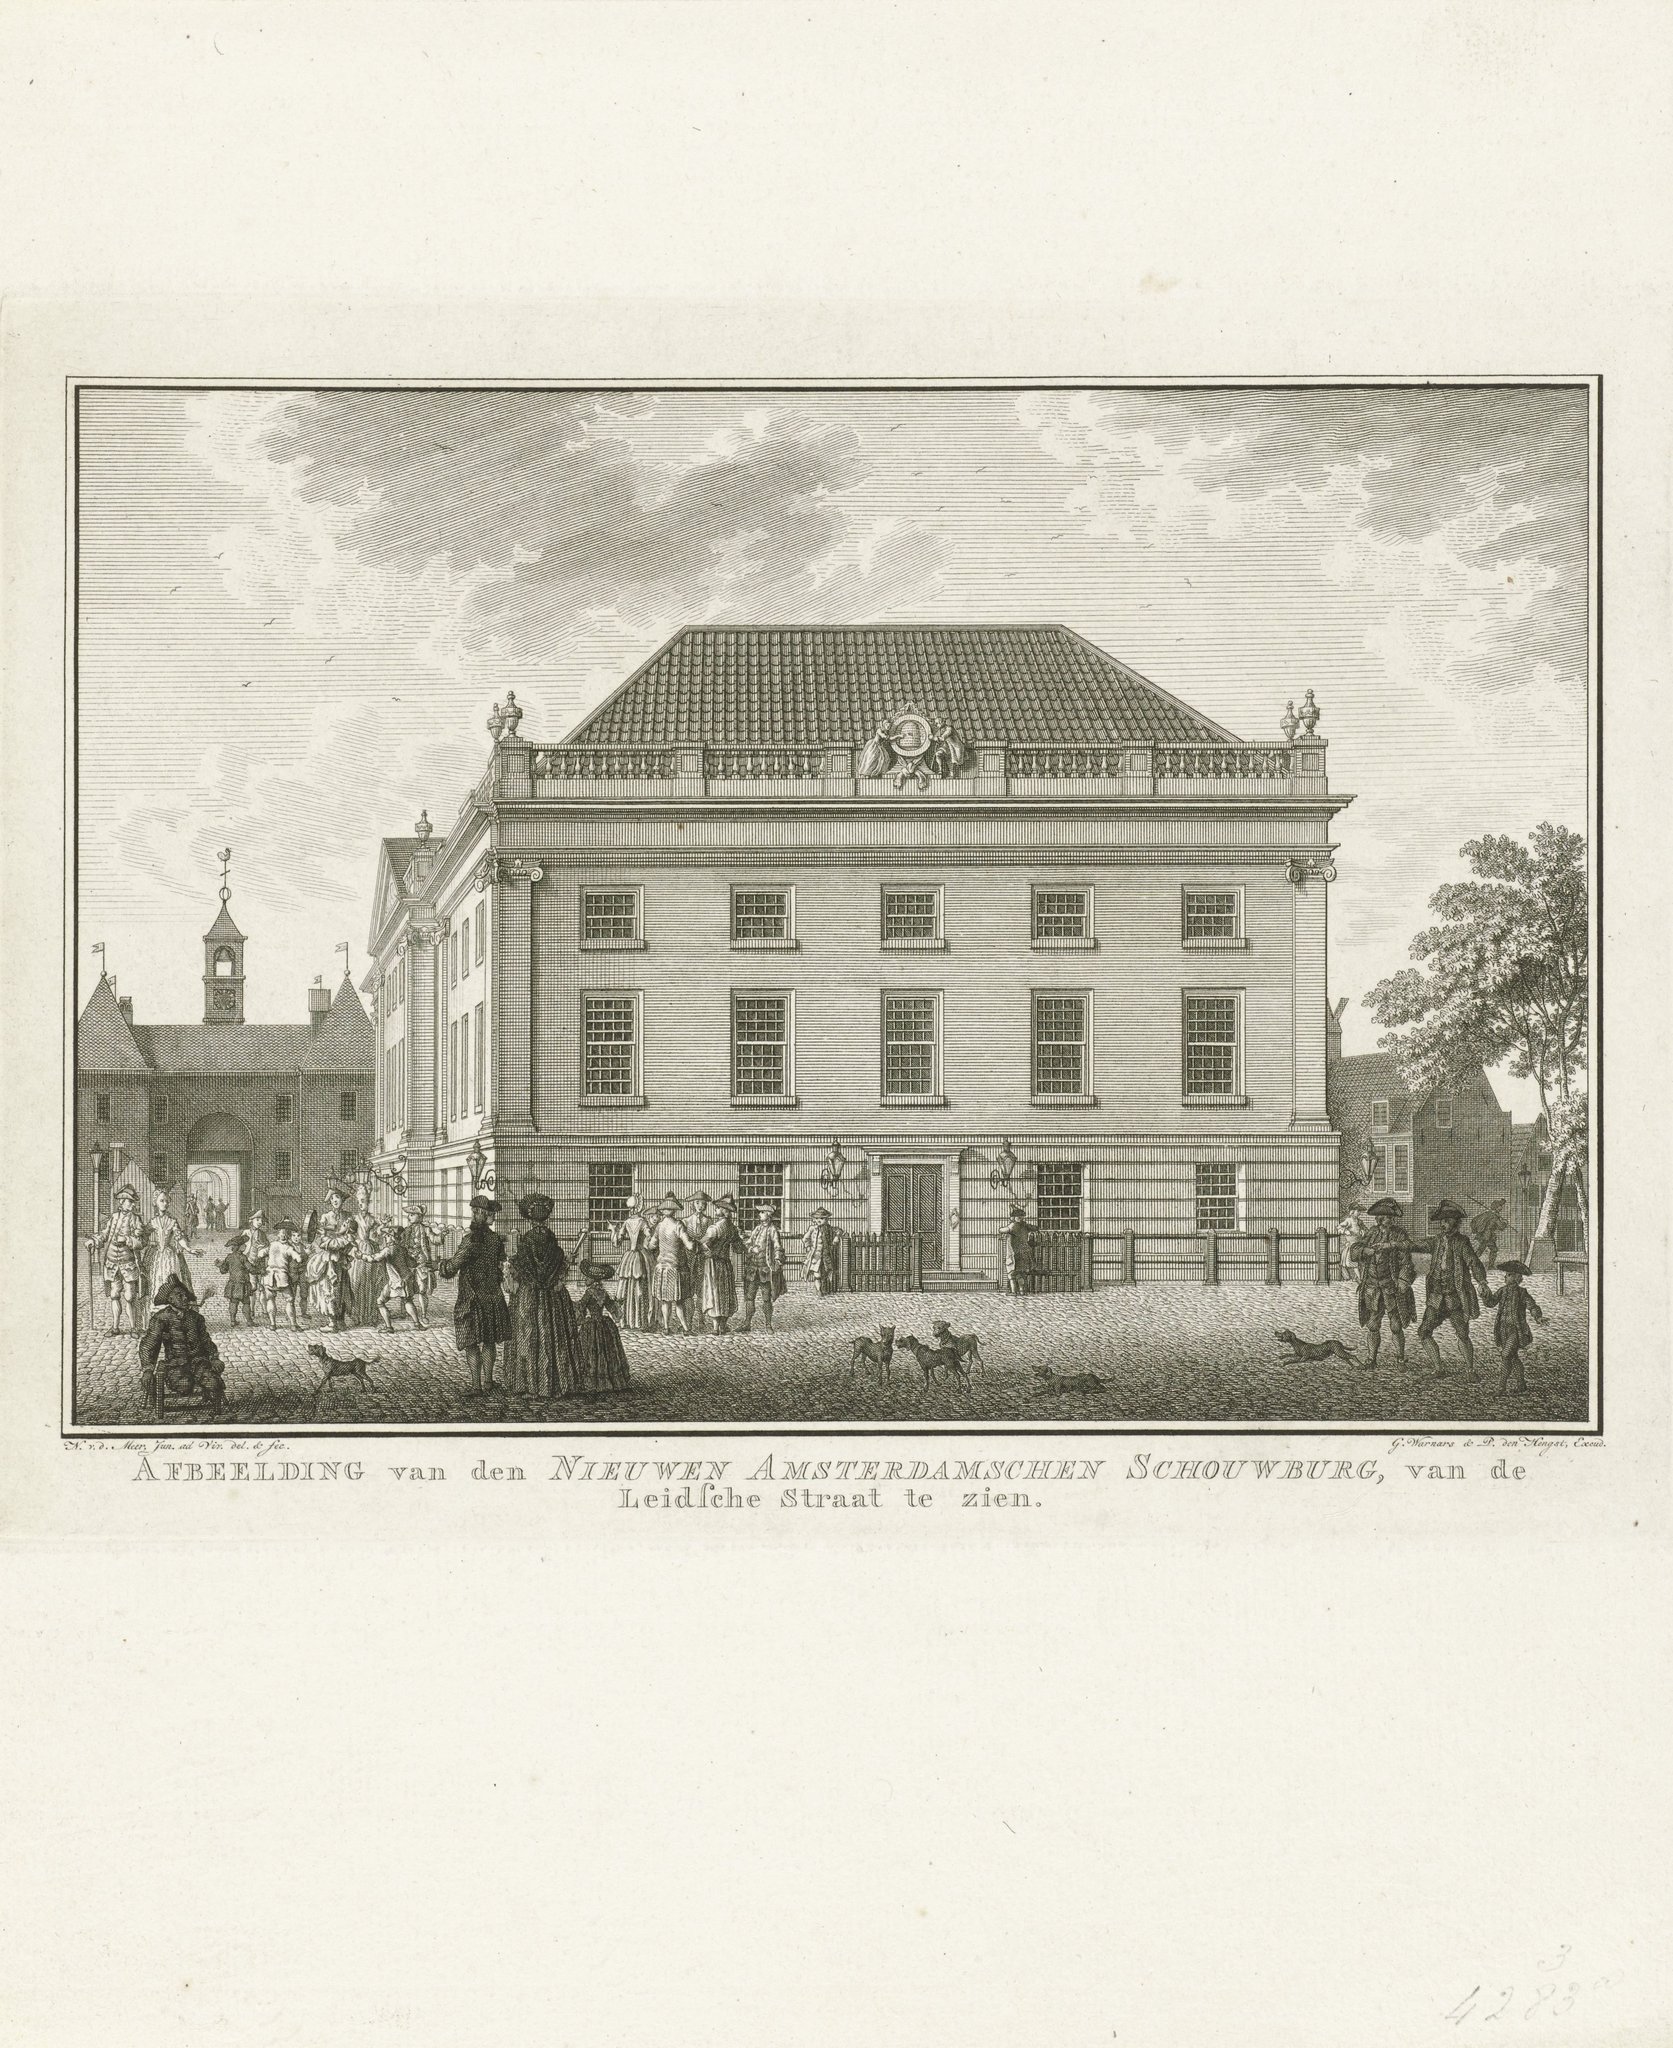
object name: book illustration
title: Afbeelding van den Nieuwen Amsterdamschen Schouwburg, van de Leidsche Straat te zien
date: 1774-1775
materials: paper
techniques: engraving, etching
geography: amsterdam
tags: theatre (building), city-gate, square, place, circus, etc. (+ city(-scape) with figures, staffage)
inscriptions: collector's mark: Lugt 2228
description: Gezicht op de zijkant van de op 15 september 1774 ingewijde Amsterdamse Schouwburg op het Leidseplein, gezien vanuit de Leidsestraat. Links op de achtergrond de Leidsepoort. Deze stadsschouwburg werd gebouwd om de in 1772 afgebrande schouwburg aan de Keizersgracht te vervangen en brandde in 1890 zelf af. Links op de voorgrond zit Swarte Klaas op zijn krukje pijp te roken. Rechts achter hem staat Prulla, een ander bekend straatfiguur uit die tijd, met haar spreektrompet.